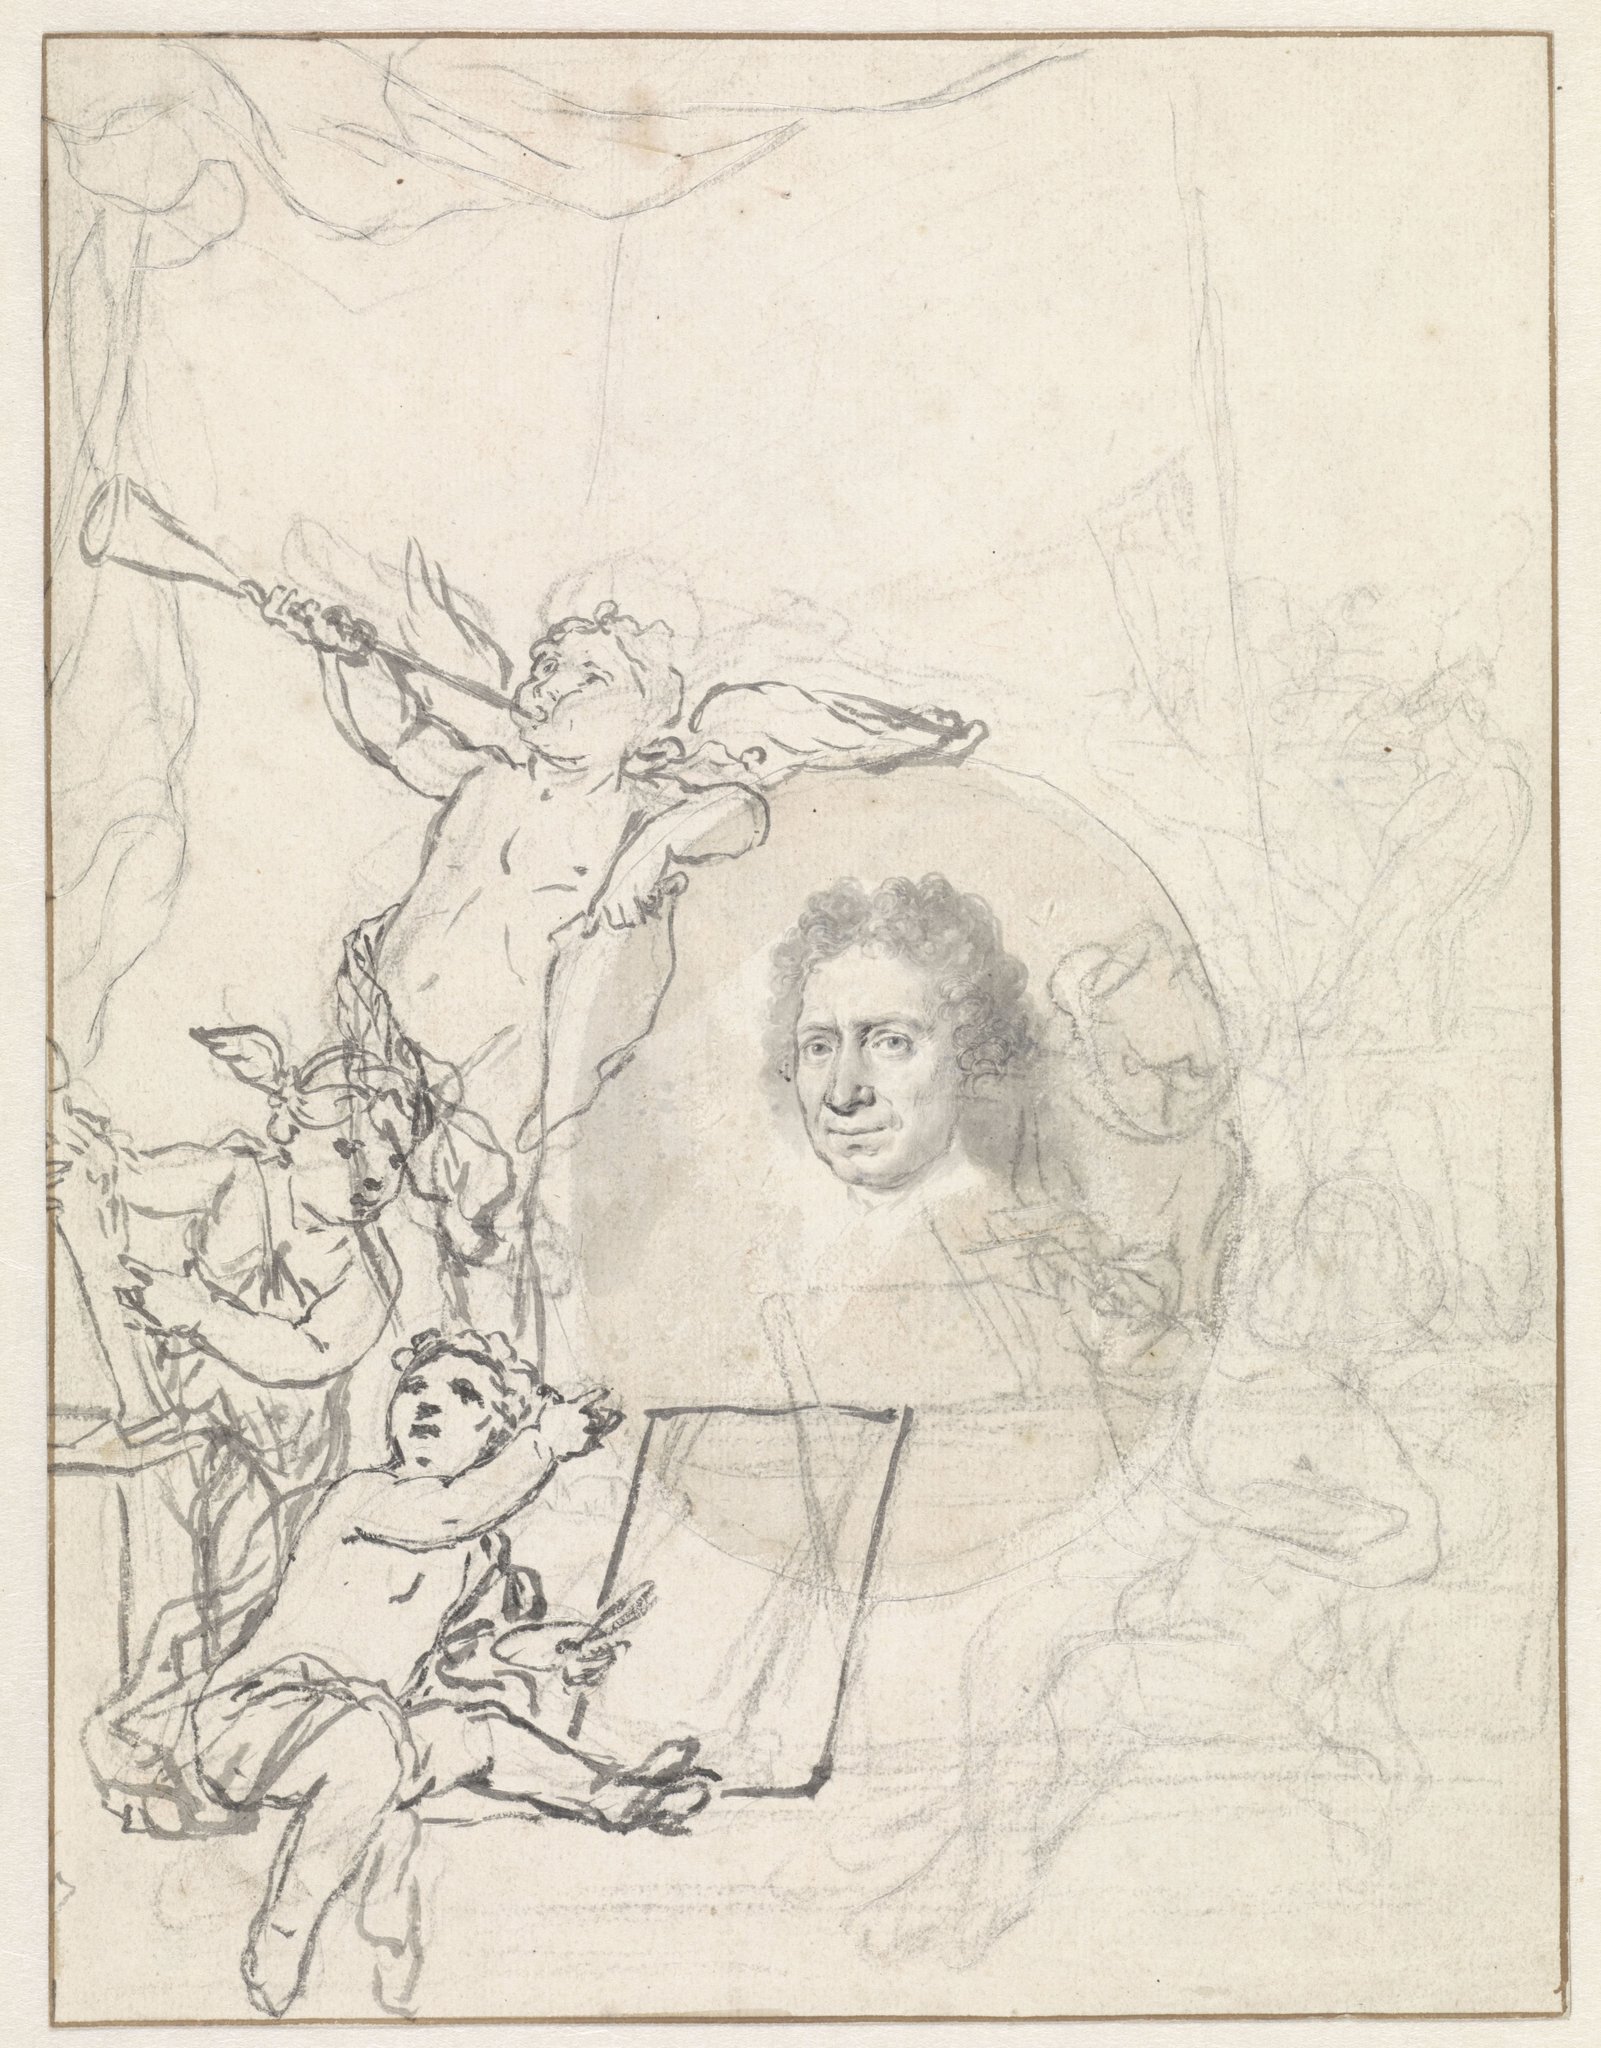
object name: drawing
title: Portret van Johannes Bronkhorst omringd door putti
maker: nicolaas verkolje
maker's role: draughtsman, painter, print maker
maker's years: 1673-1746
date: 1720-1725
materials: paper, pencil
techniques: brush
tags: leiden, draughtsman, johannes bronkhorst, historical persons, portrait, self-portrait of painter, portrait, self-portrait of artist, portrait, self-portrait of draughtsman